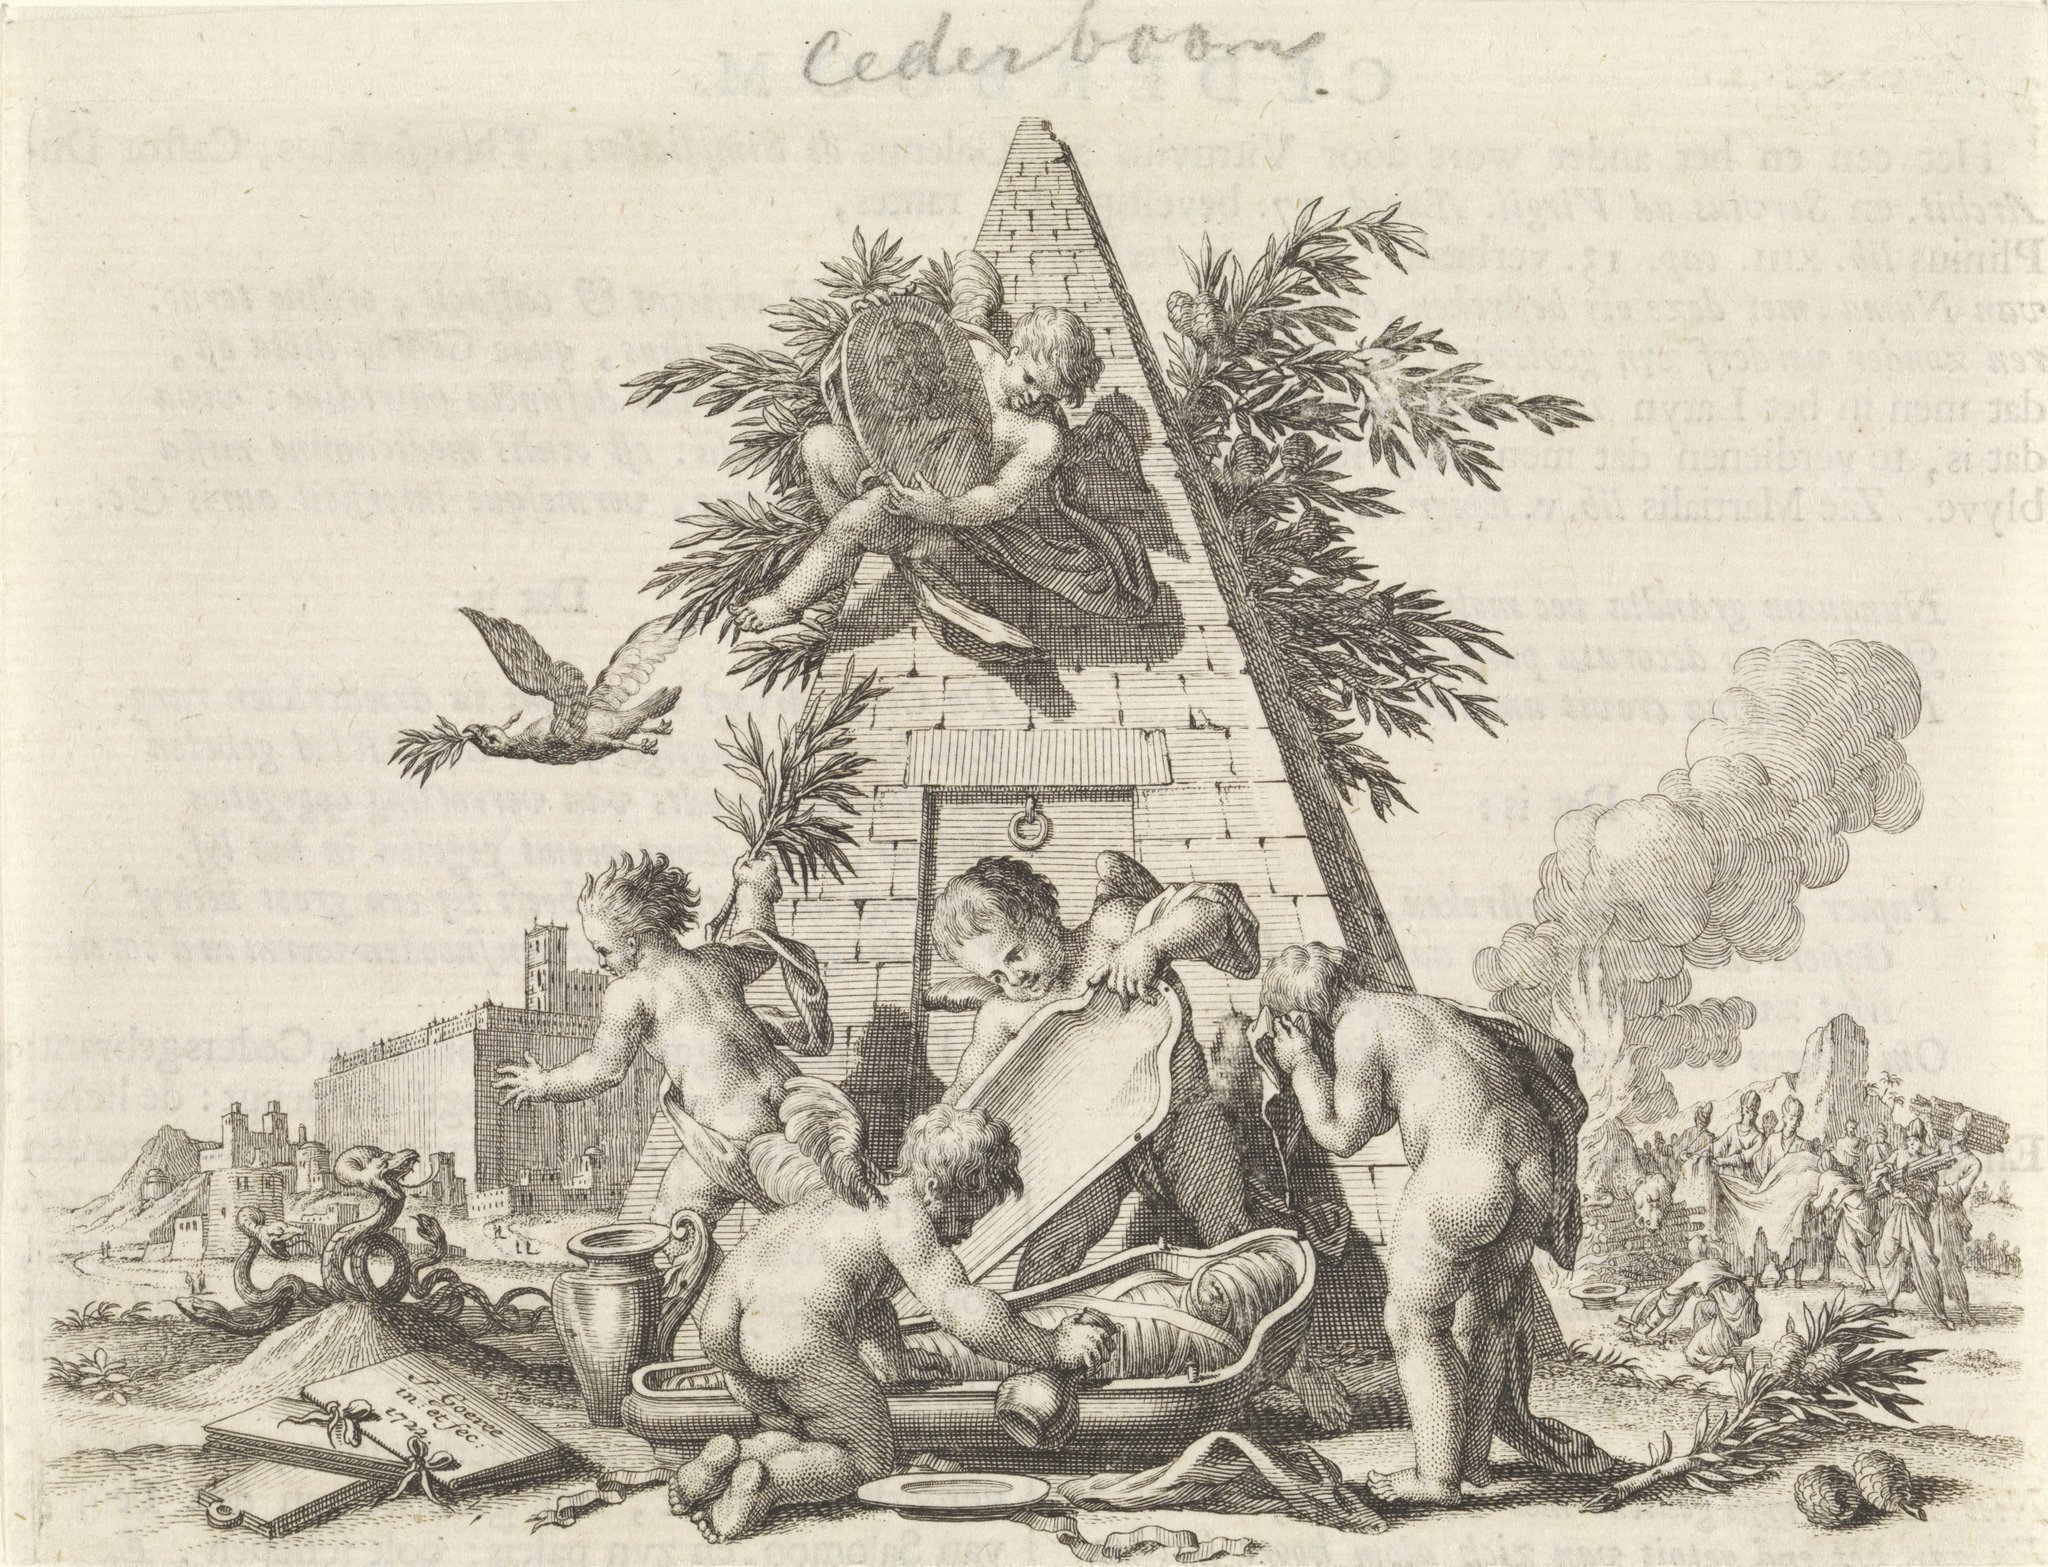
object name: book illustration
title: Embleem: cederboom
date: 1722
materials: paper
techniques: engraving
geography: amsterdam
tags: sarcophagus, pyramid (historical grave form), sacrifice of animals ~ jewish religion, cupids: 'amores', 'amoretti', 'putti', ezekiel's parable of the cedar-tree and the eagles (ezekiel 17), mummy, embalming, mummification of the corpse, trees: cedar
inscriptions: date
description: Enkele putti balsemen met cederolie een mummie in een sarcofaag. Achter hen een piramide met een cederboom. Rechts in de achtergrond wordt een rund geofferd op een brandstapel van cederhout. Links op de achtergrond een arend die een cedertak naar Babel voert.